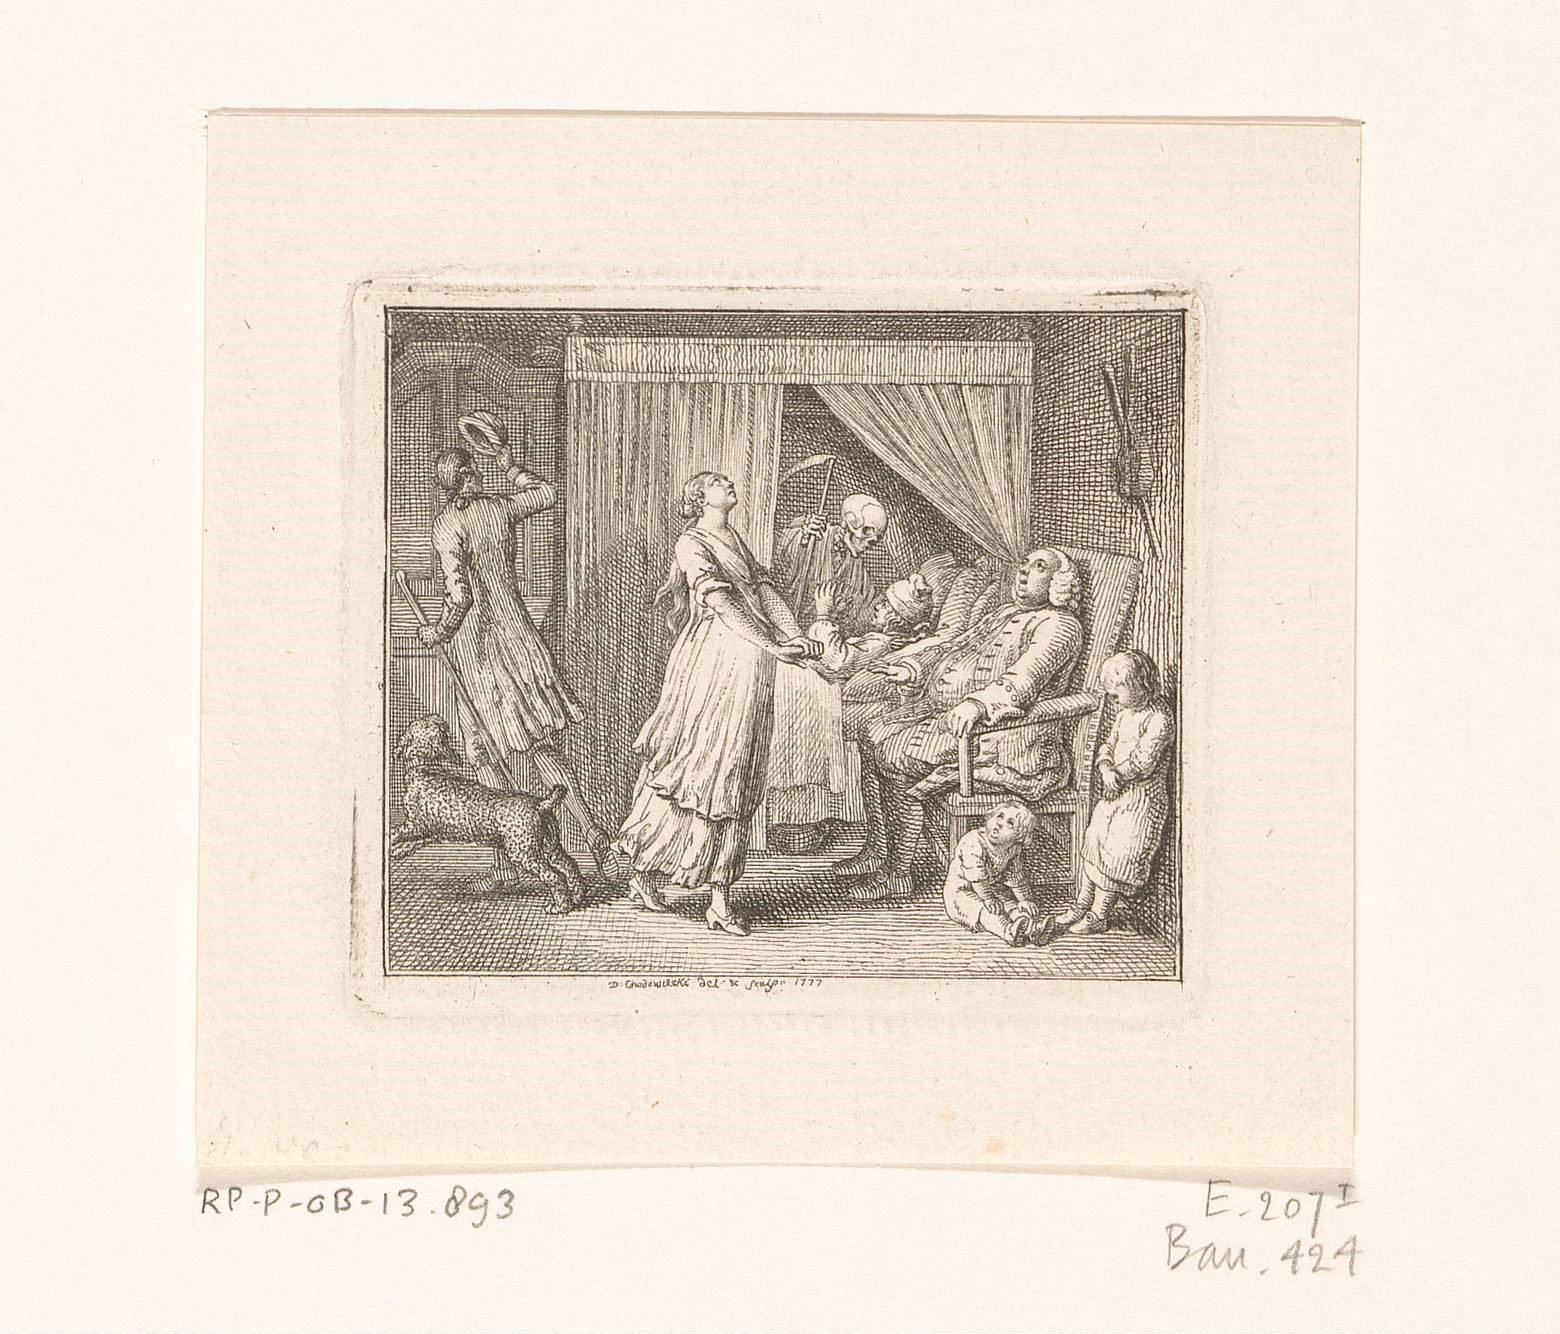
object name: print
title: Zieke man bezocht door de dood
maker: daniel nikolaus chodowiecki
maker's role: draughtsman, print maker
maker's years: 1726-1801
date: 1777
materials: paper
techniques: etching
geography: berlin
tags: draughtsman, matthias claudius, literature, sick-bed, death as skeleton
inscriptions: collector's mark: Lugt 2228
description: Prent ook gebruikt in 'Asmus omnia sua secum portans, oder Sämtliche Werke des Wandsbecker Bothen', een verzamelwerk in de vorm van een tijdschrift, uitgegeven tussen 1775-1812. Deze prent gebruikt in deel 3.